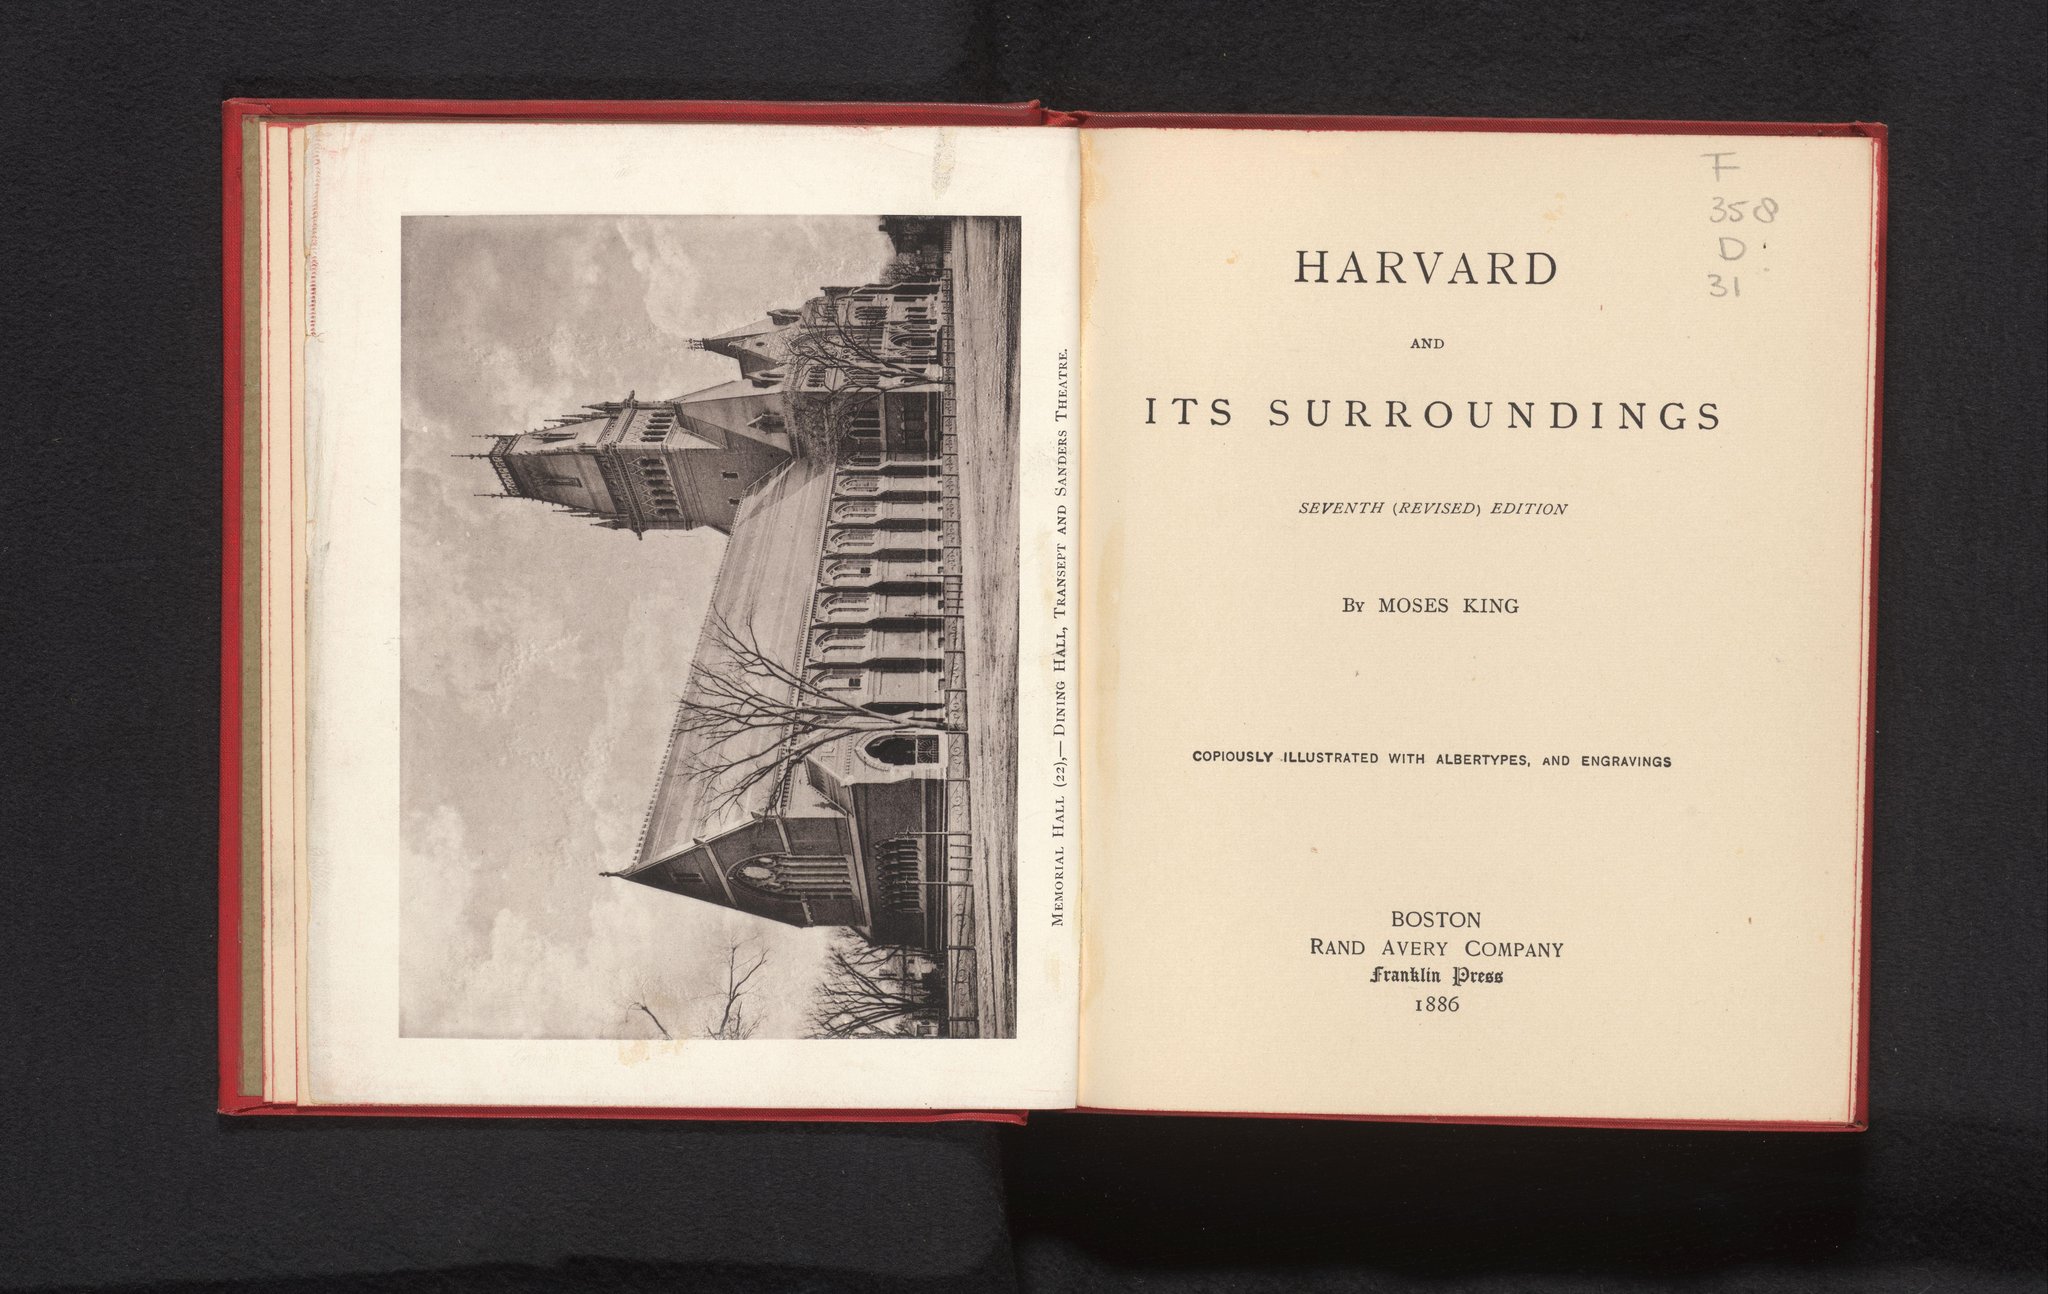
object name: book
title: Harvard and its surroundings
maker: moses king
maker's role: publisher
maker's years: 1853-1909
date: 1886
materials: cardboard, linen, paper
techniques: photograph, printing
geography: boston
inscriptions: inscription: ‘Marie Rehberg Cambridge May 31st 1890. Ball [...] !! Tramp Professor. Your Friends' Parsimony Extravagance’